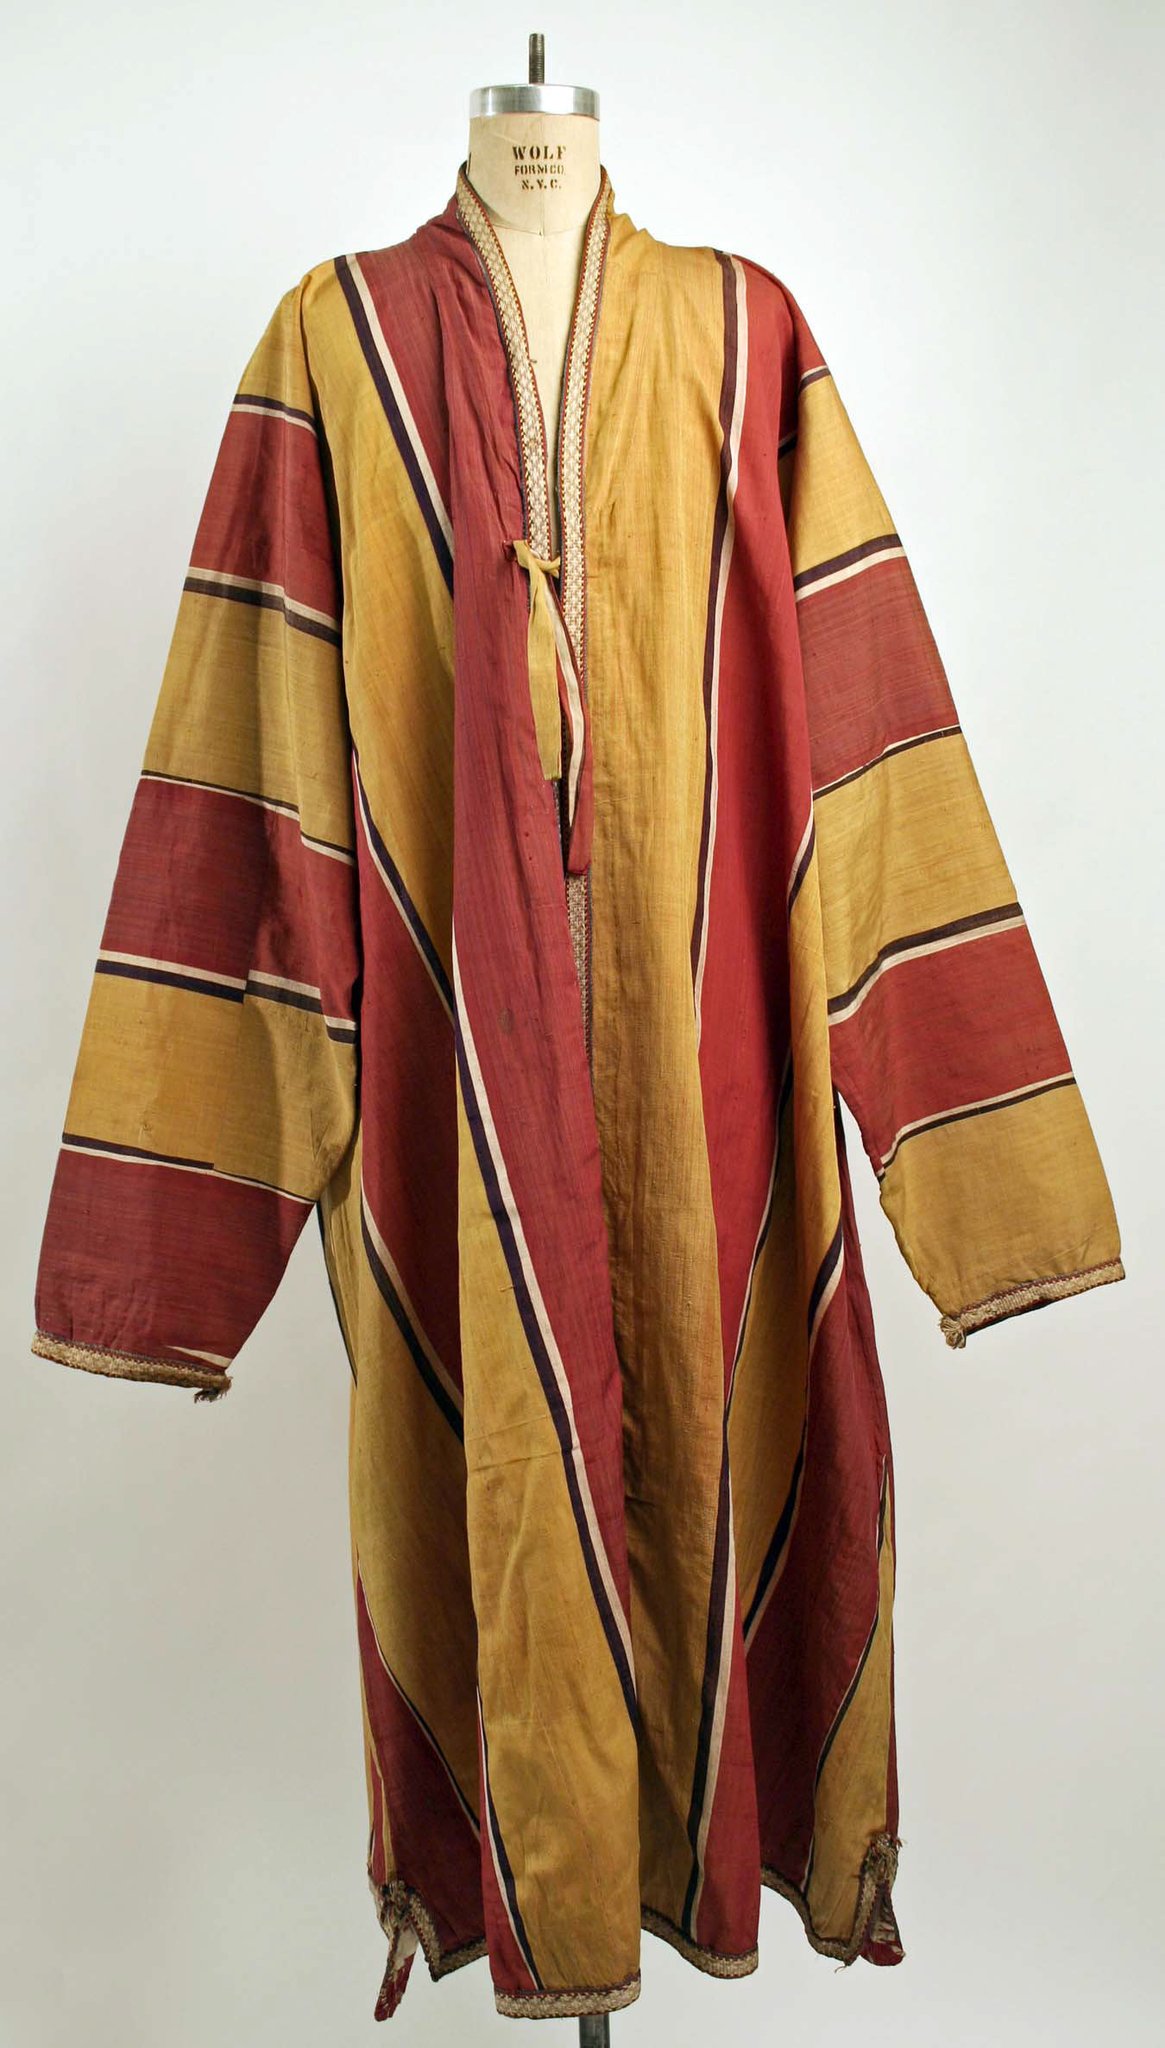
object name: ensemble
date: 1801-1900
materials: silk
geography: uzbekistan